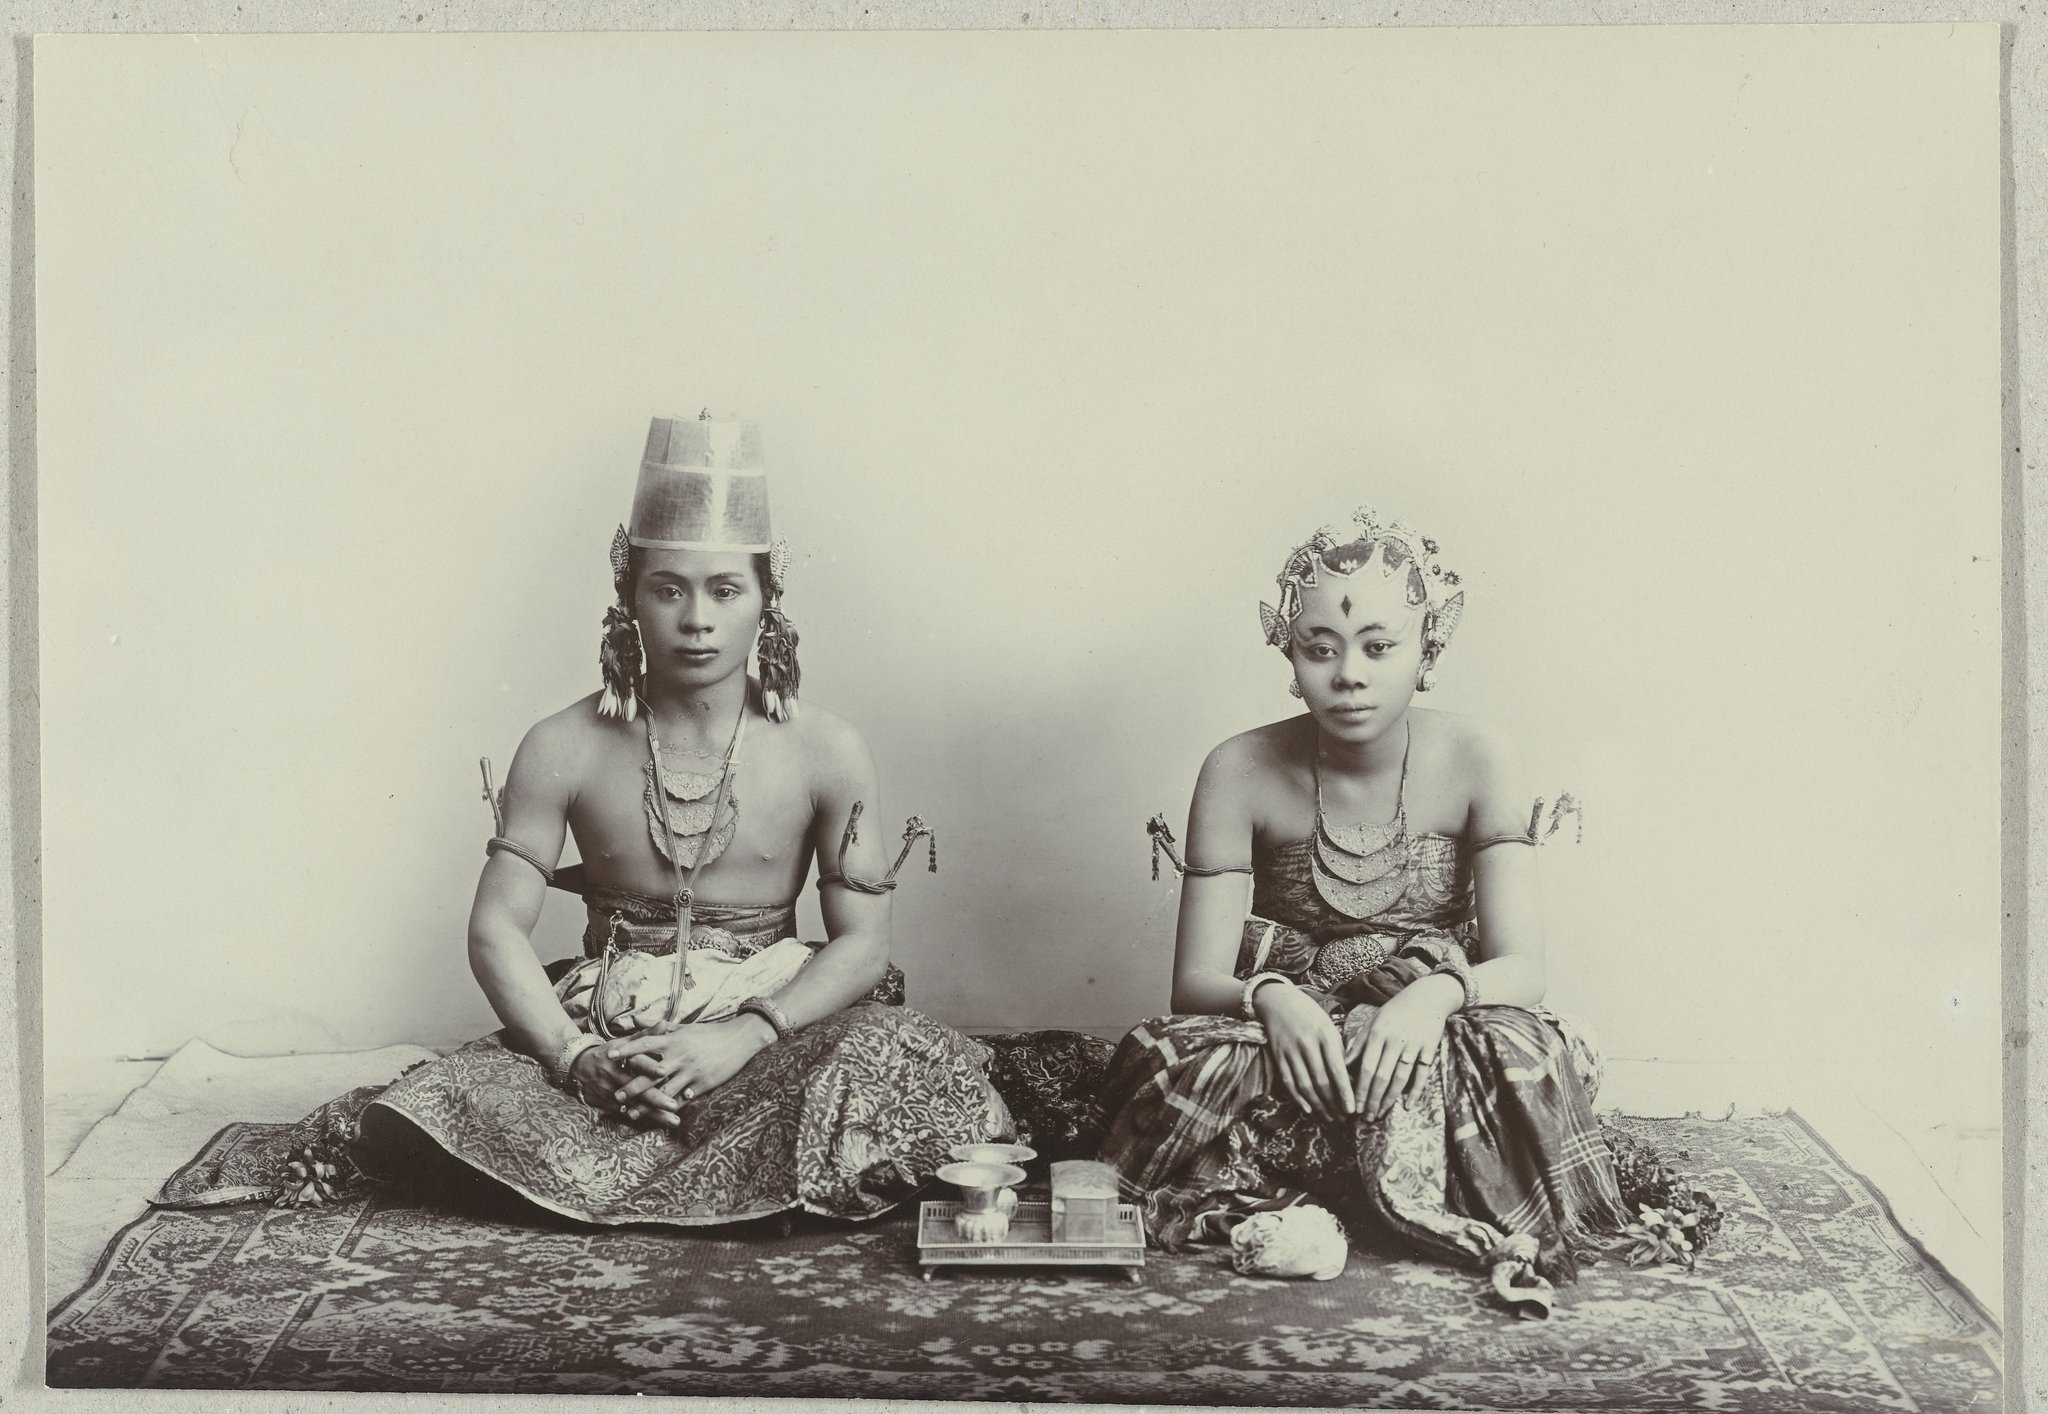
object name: photograph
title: Studioportret van een zittende jonge Javaanse man en vrouw dragend een batik sarong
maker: kassian céphas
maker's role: fotograaf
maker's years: 1845-1912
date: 1870-1912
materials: cardboard, paper, photographic support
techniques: albumen print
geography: java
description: Studioportret van een jonge Javaanse vrouw en man zittend op de grond. Beide dragen vele sieraden op het lichaam en het hoofd. Tevens dragen beiden een batik sarong. De vrouw is wit gepoederd.